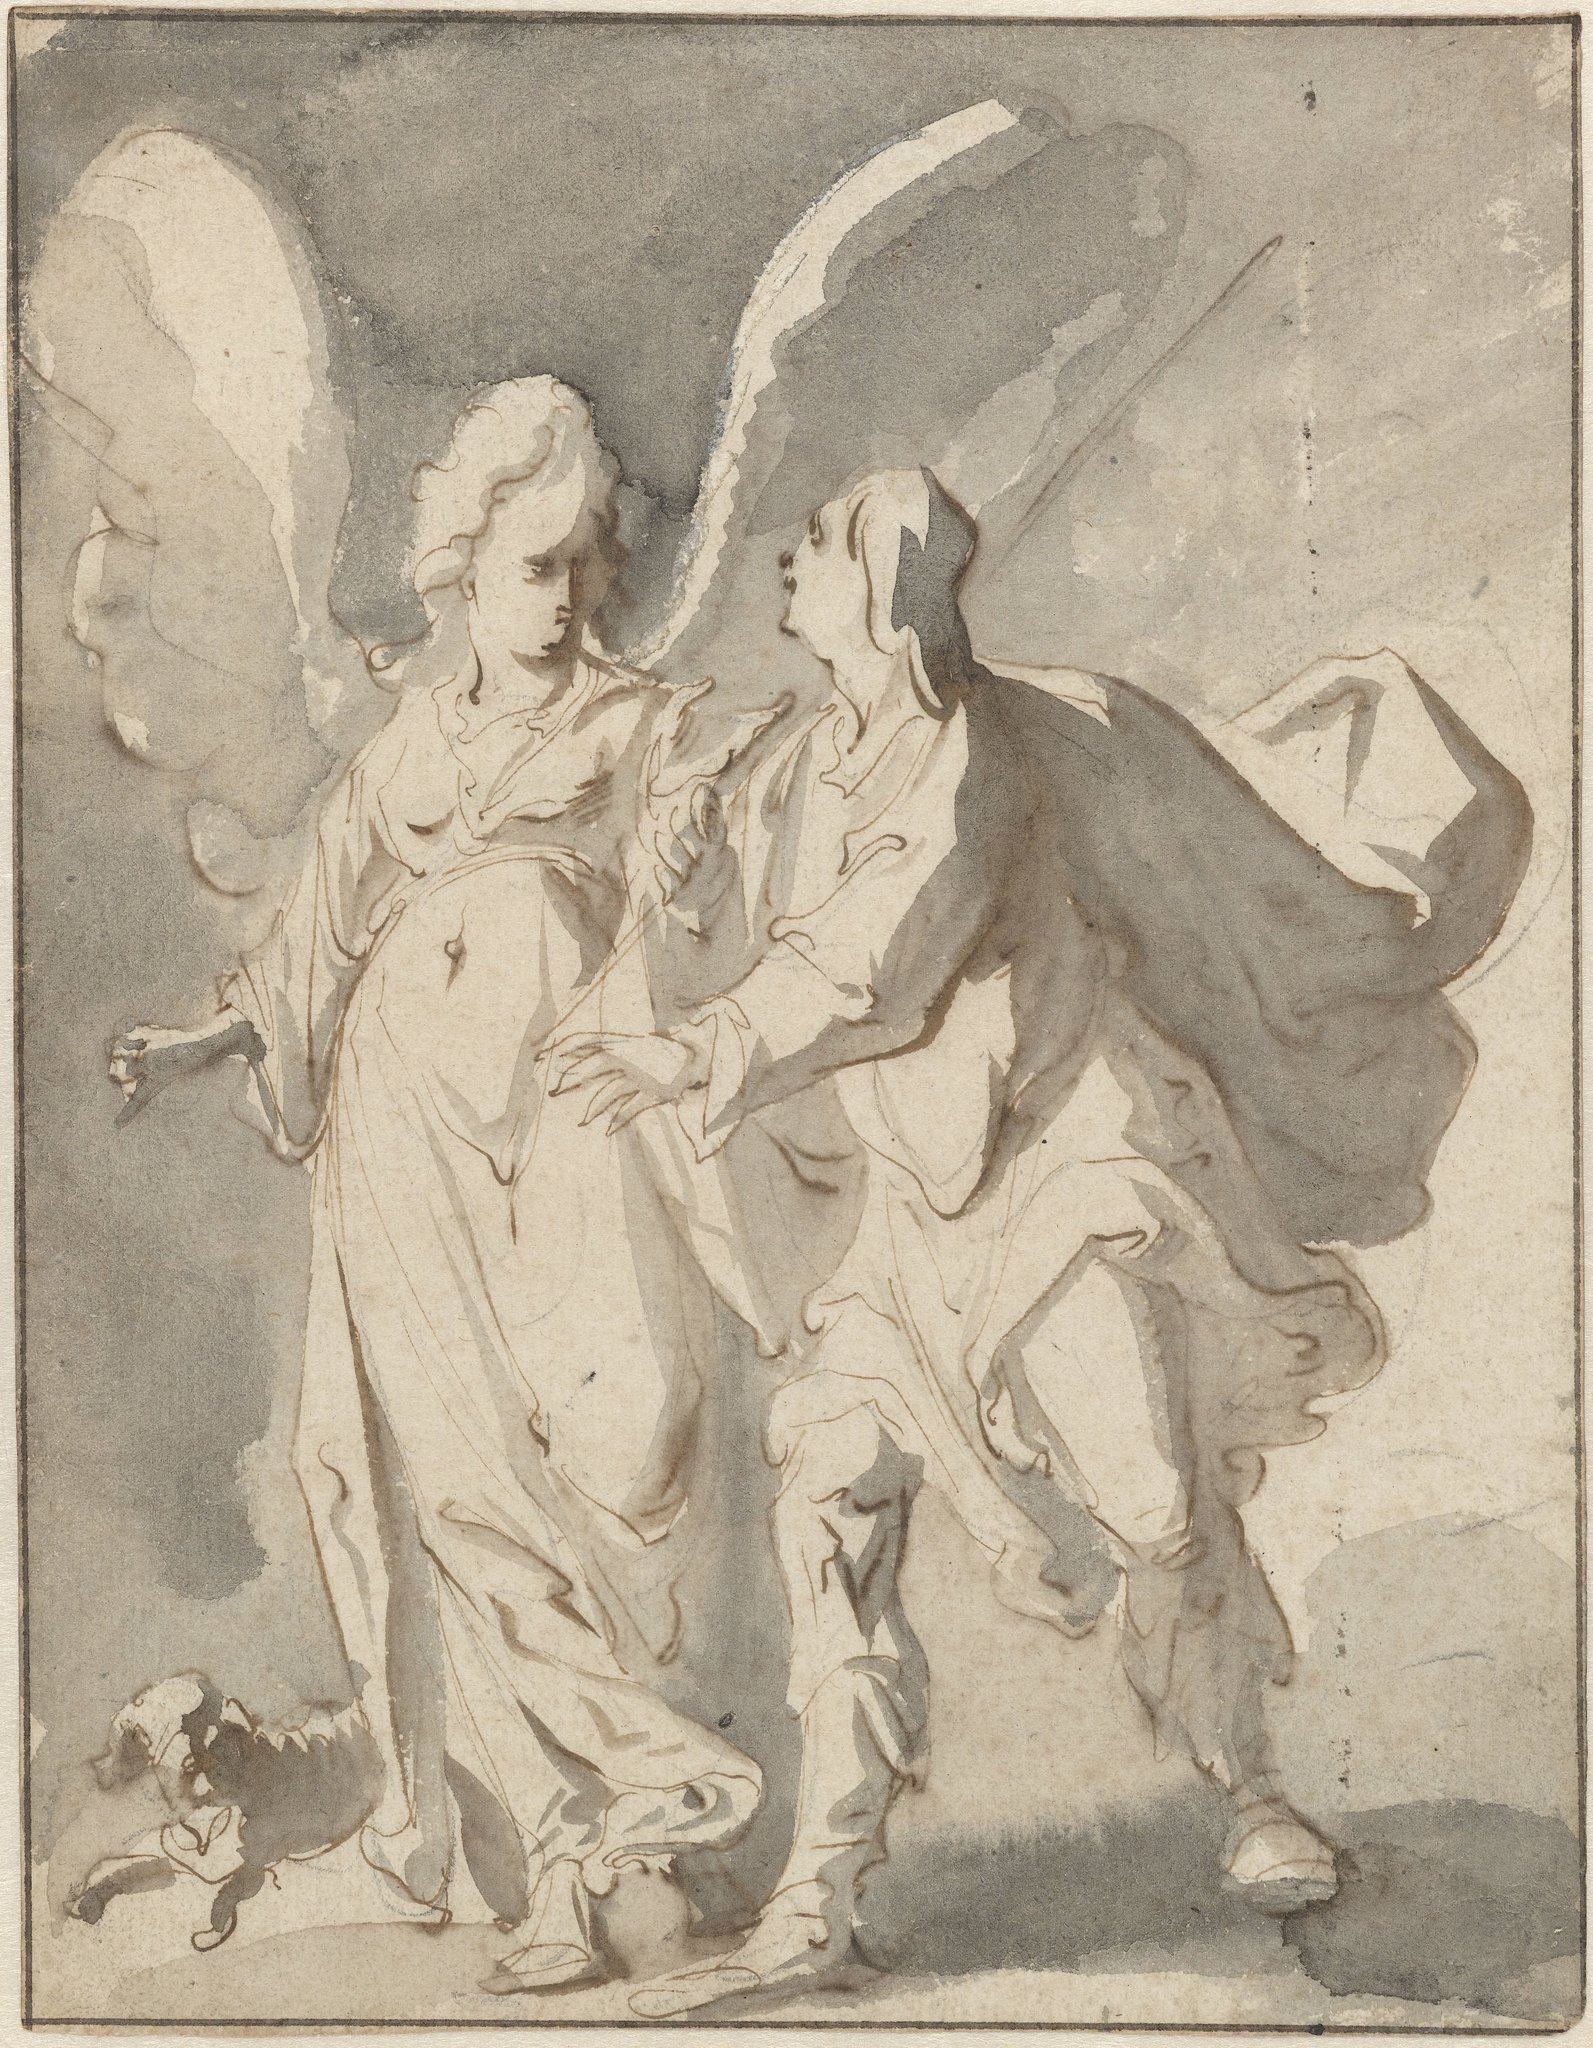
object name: drawing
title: Tobias en de engel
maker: pieter jansz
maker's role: draughtsman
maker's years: 1602-1672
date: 1655-1669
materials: chalk, graphite, ink, paper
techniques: brush, pen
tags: tobias and the angel raphael travelling, accompanied by tobias' dog